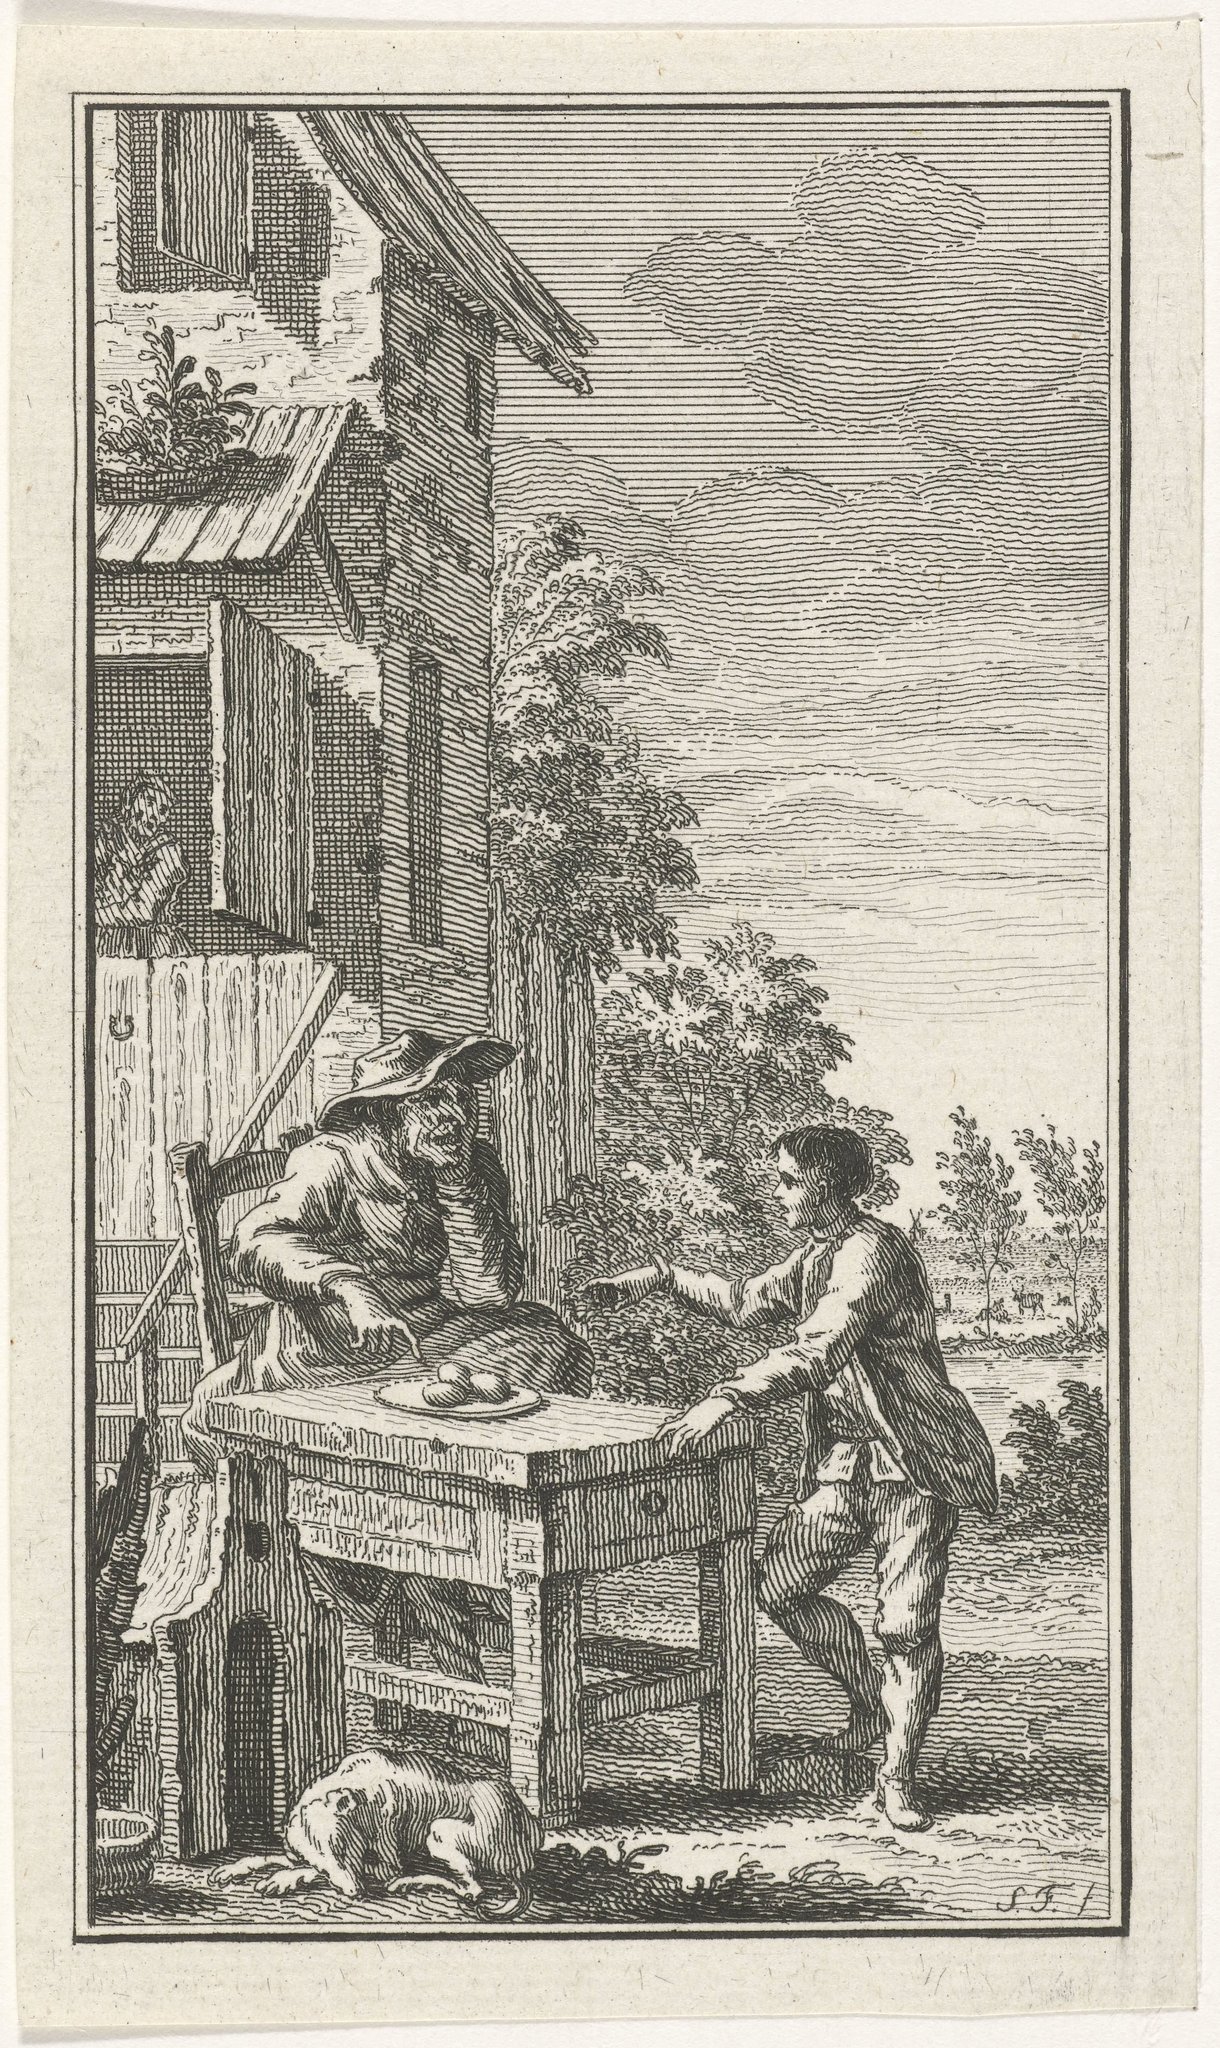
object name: print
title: Oude vrouw biedt jongen een ei aan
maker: simon fokke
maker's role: draughtsman, print maker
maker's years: 1712-1784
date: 1722-1784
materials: paper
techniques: etching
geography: amsterdam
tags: child, old woman, eggs, egg-dishes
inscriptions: collector's mark: Lugt 240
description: Voor een huis staat in de buitenlucht een tafel waaraan een oude vrouw zit. Ze wijst de jongen tegenover haar op de drie eieren die op het bord voor haar liggen.